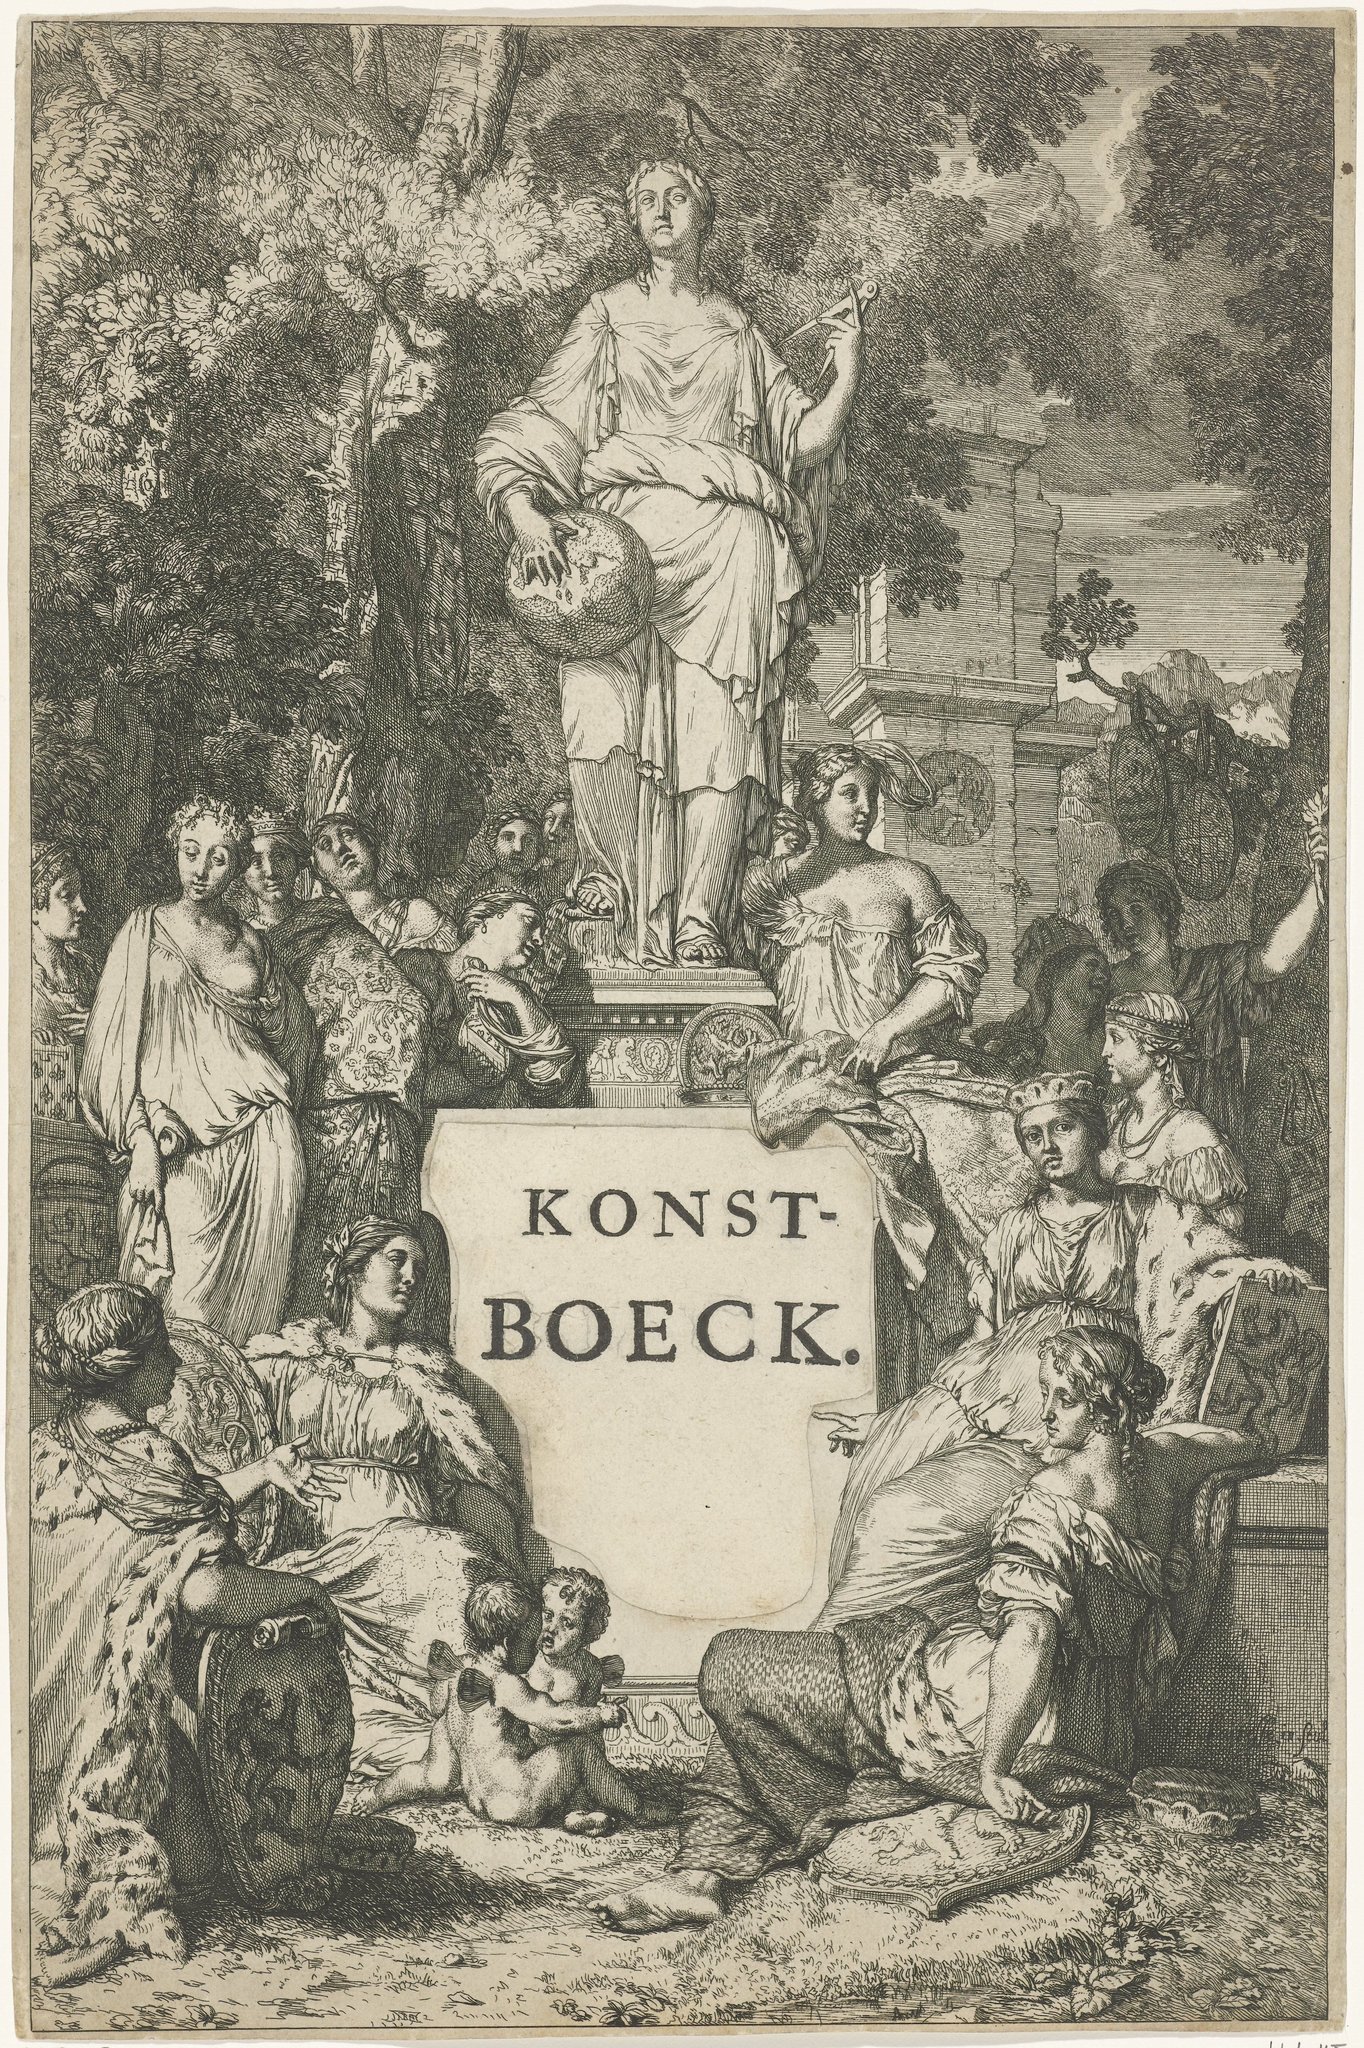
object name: print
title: Geografia omringd door de Zeventien Provinciën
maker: gerard de lairesse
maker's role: draughtsman, painter, print maker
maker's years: 1641-1711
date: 1668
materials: paper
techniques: etching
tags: personifications of countries, nations, states, districts, etc. (+ province; provincial), 'corografia', 'geografia', 'hidrografia' (ripa), armorial bearing, heraldry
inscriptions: collector's mark: Lugt 2228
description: Het standbeeld van Geografia (passer en wereldbol) staat op een sokkel en wordt omringd door de personificaties van de Zeventien Provinciën. Een aantal van deze personificaties houdt het wapen van een provincie in de hand. Op de sokkel is de oorspronkelijke titel van het boek uitgeknipt en vervangen door: Konst-boeck.